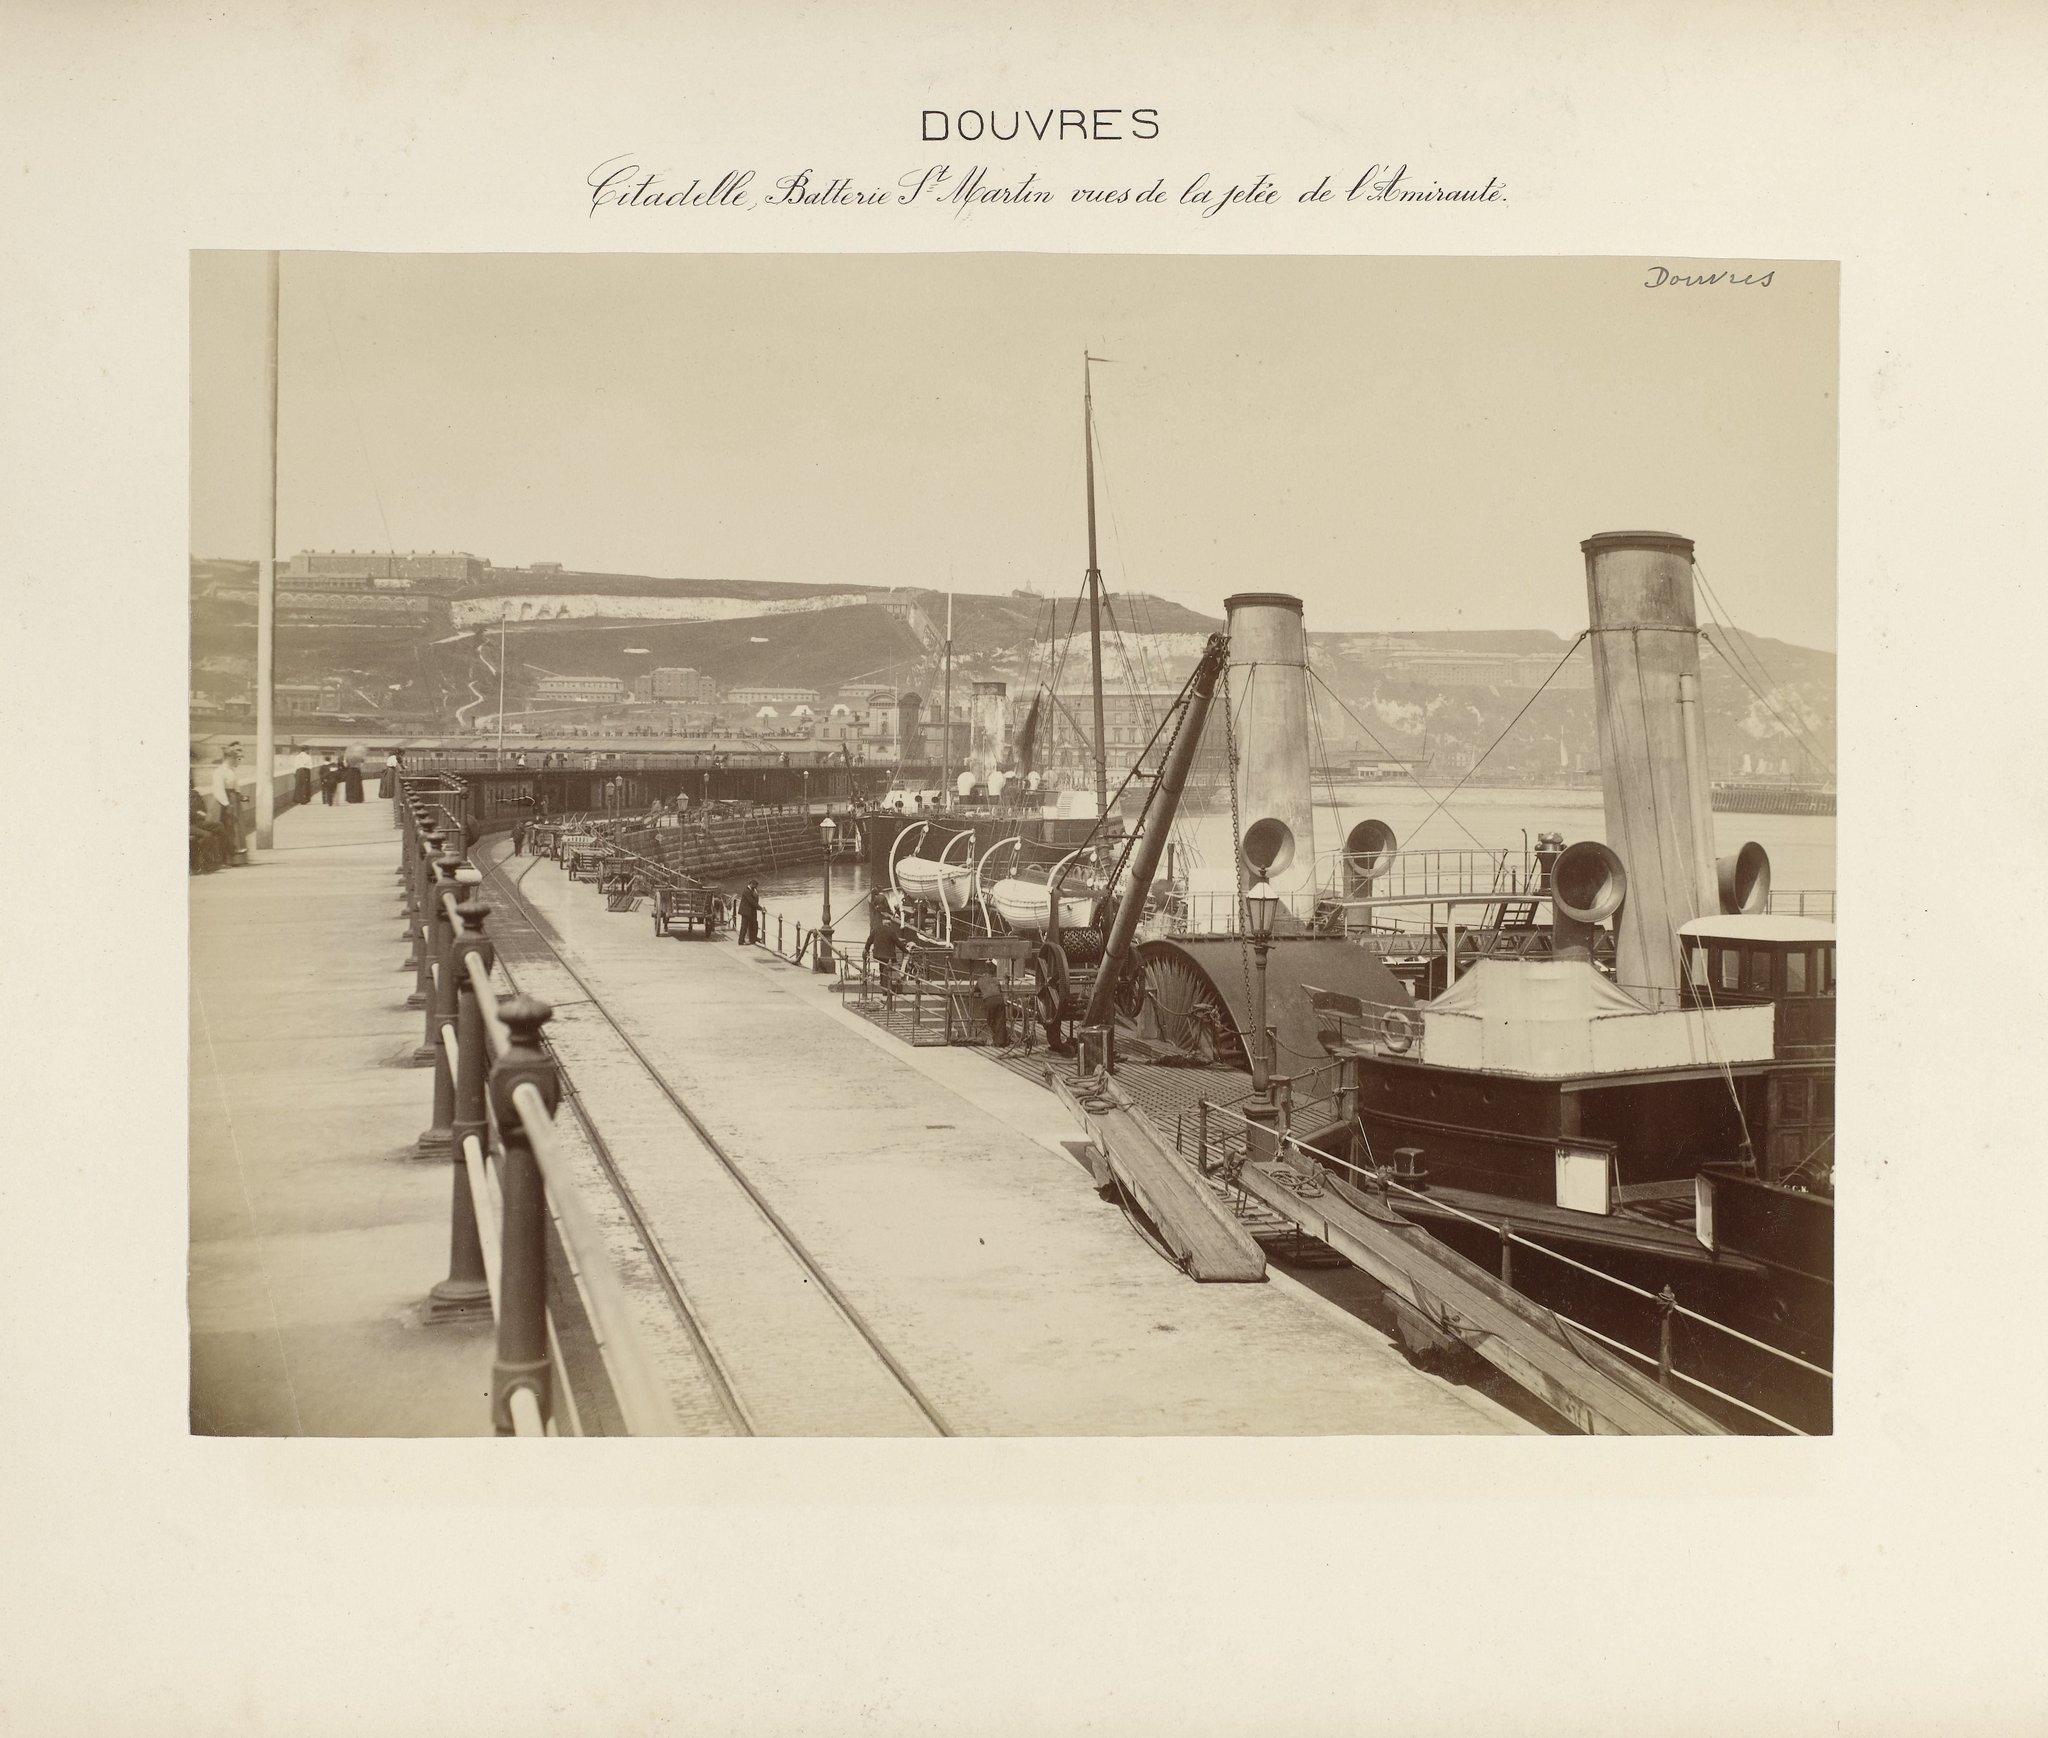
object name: photograph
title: Angleterre. Défense des côtes. Reconaissance de 1891. Photographies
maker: Anonymous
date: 1891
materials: cardboard, paper, photographic support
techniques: albumen print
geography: great britain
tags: dover (engeland)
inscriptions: inscription: ‘Douvres’, inscription: ‘DOUVRES / Citadelle, Batterie St Martin vues de la jetée de l'Admirauté’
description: Foto uit een album met 35 topografische foto's van Britse kustplaatsen, waarop in pen militaire verdedigingswerken zijn aangegeven door een Franse militair.